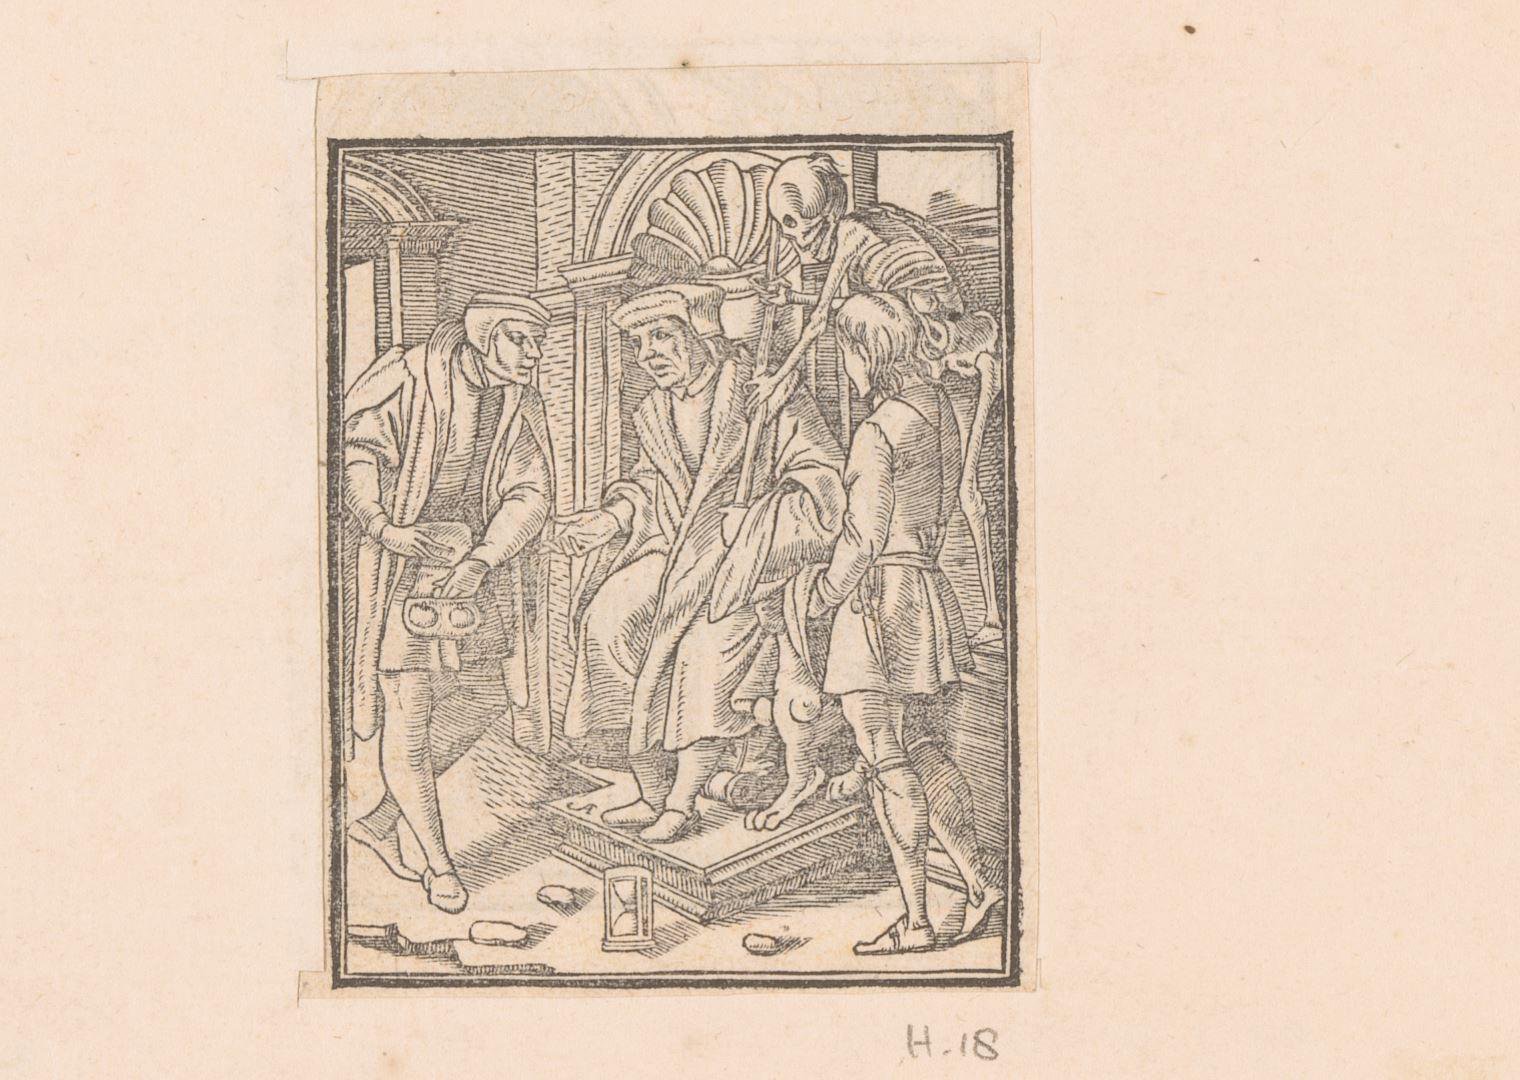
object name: book illustration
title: Kopieën naar Holbeins Dodendans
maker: Anonymous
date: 1547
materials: paper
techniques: woodcut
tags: dance of death; death together with one or more human beings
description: Kopie van een prent van Hans Holbein de jongere uit 1538, voor het eerst gepubliceerd in: Imagines mortis (...). Lyon: Johannes Frellon, 1547.